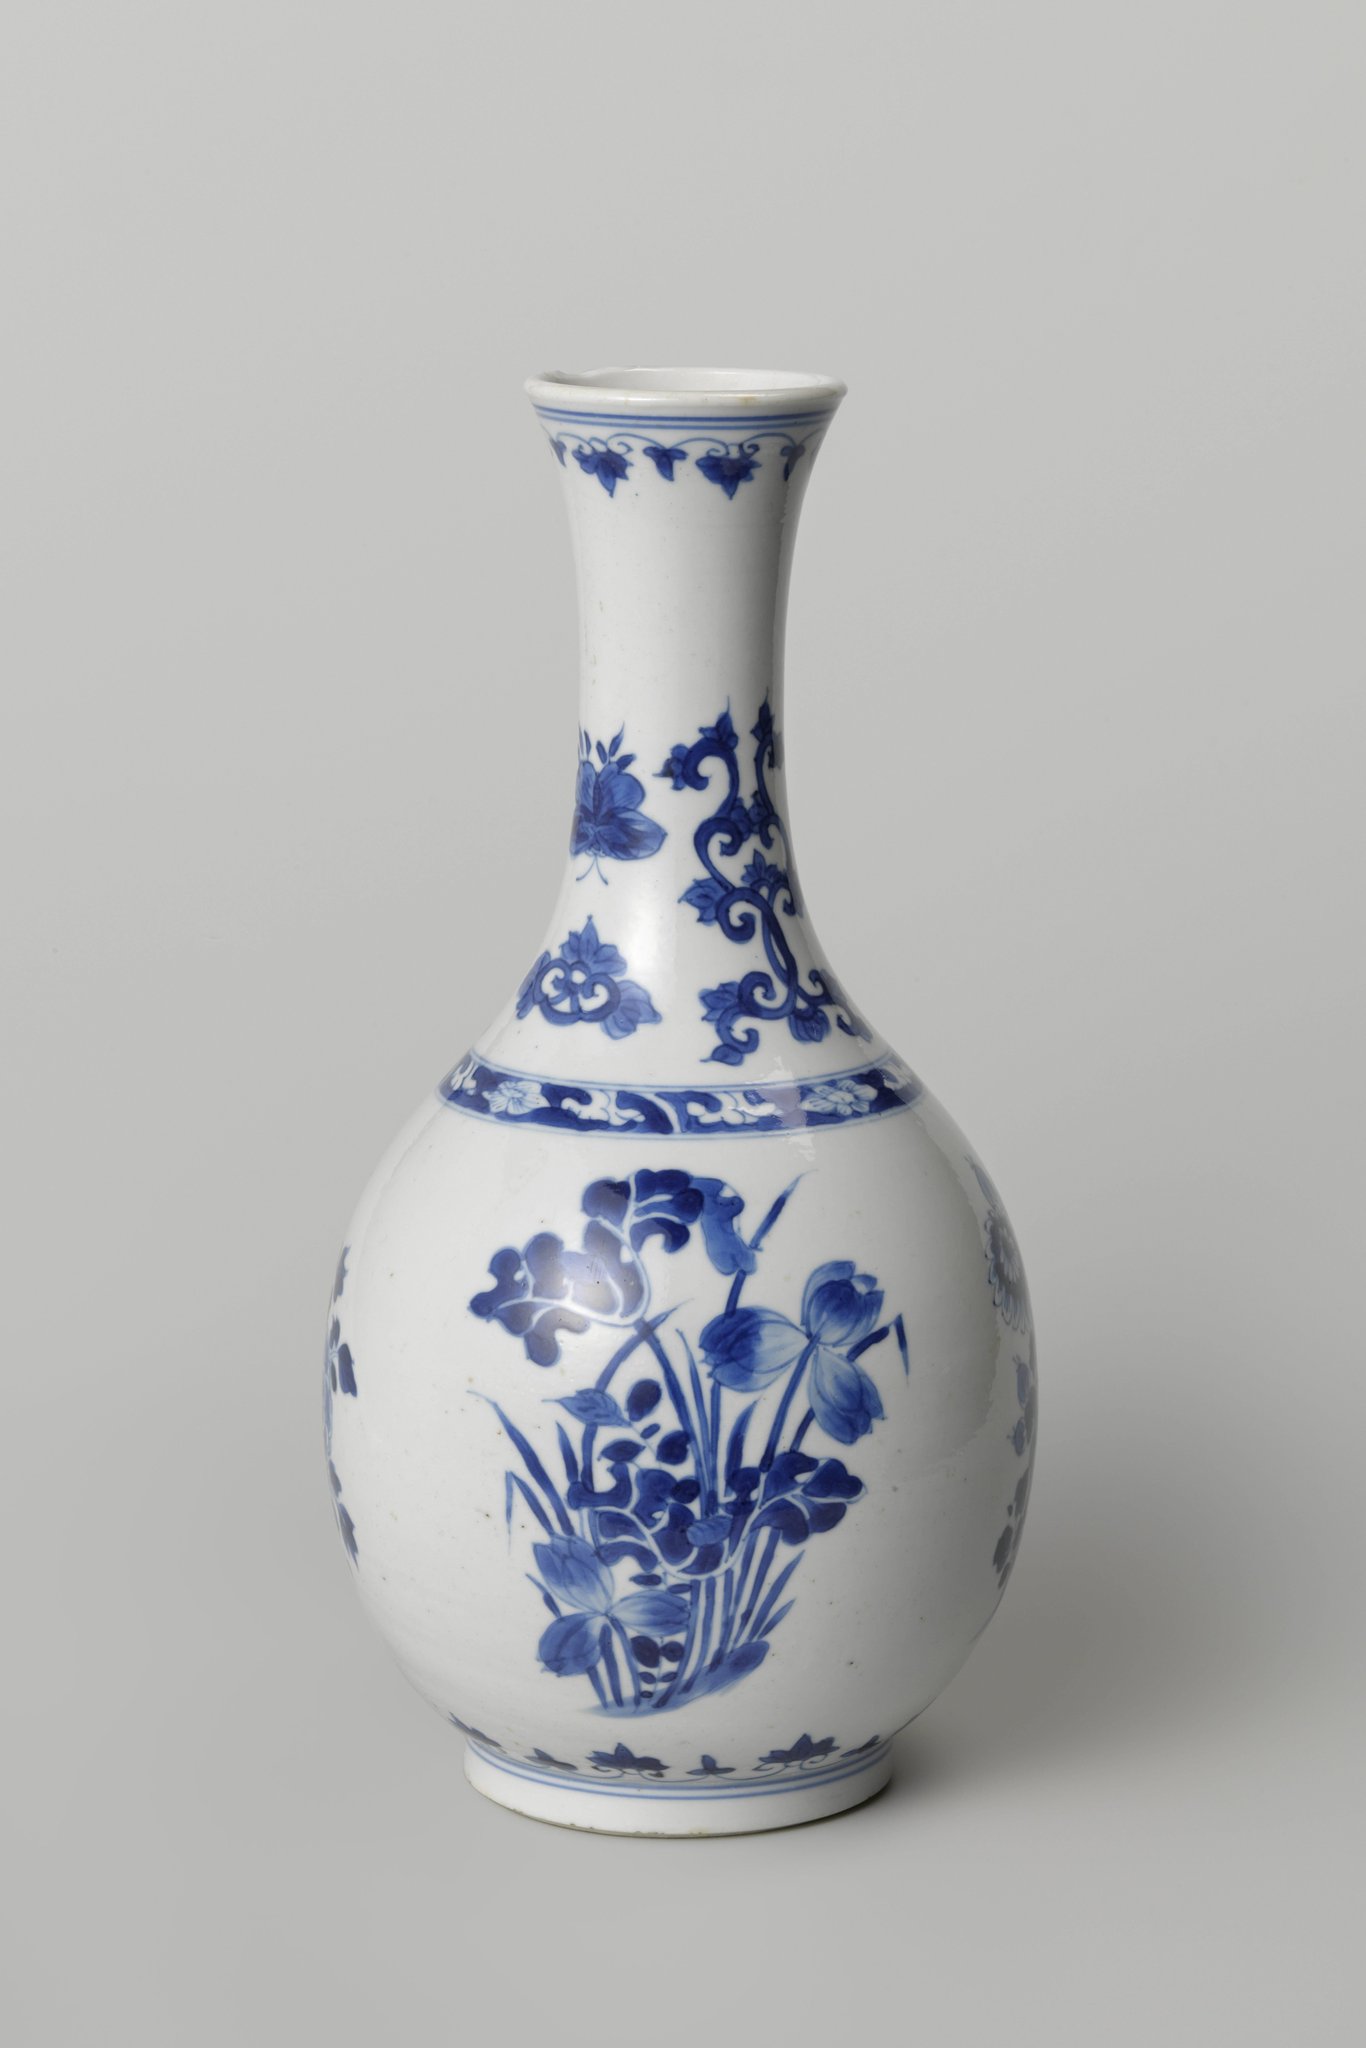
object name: vase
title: Pear-shaped bottle vase with flowering plants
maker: Anonymous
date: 1680-1720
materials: cobalt, glaze, paint, porcelain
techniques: firing, turning, vitrification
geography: china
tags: bunch of flowers ~ ornament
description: Flesvormige vaas van porselein met een peervormig lichaam en spreidende nek, beschilderd in onderglazuur blauw. Op de buik zijn bloeiende planten, de vier jaargetijdenbloemen, afgebeeld: pioenroos (lente), lotus (zomer), chrysant (herfst) en prunus (winter). Op de nek bloemranken en vlinders. Boven de voet, op de rand en de schouder een band met bloemranken. Blauw-wit.